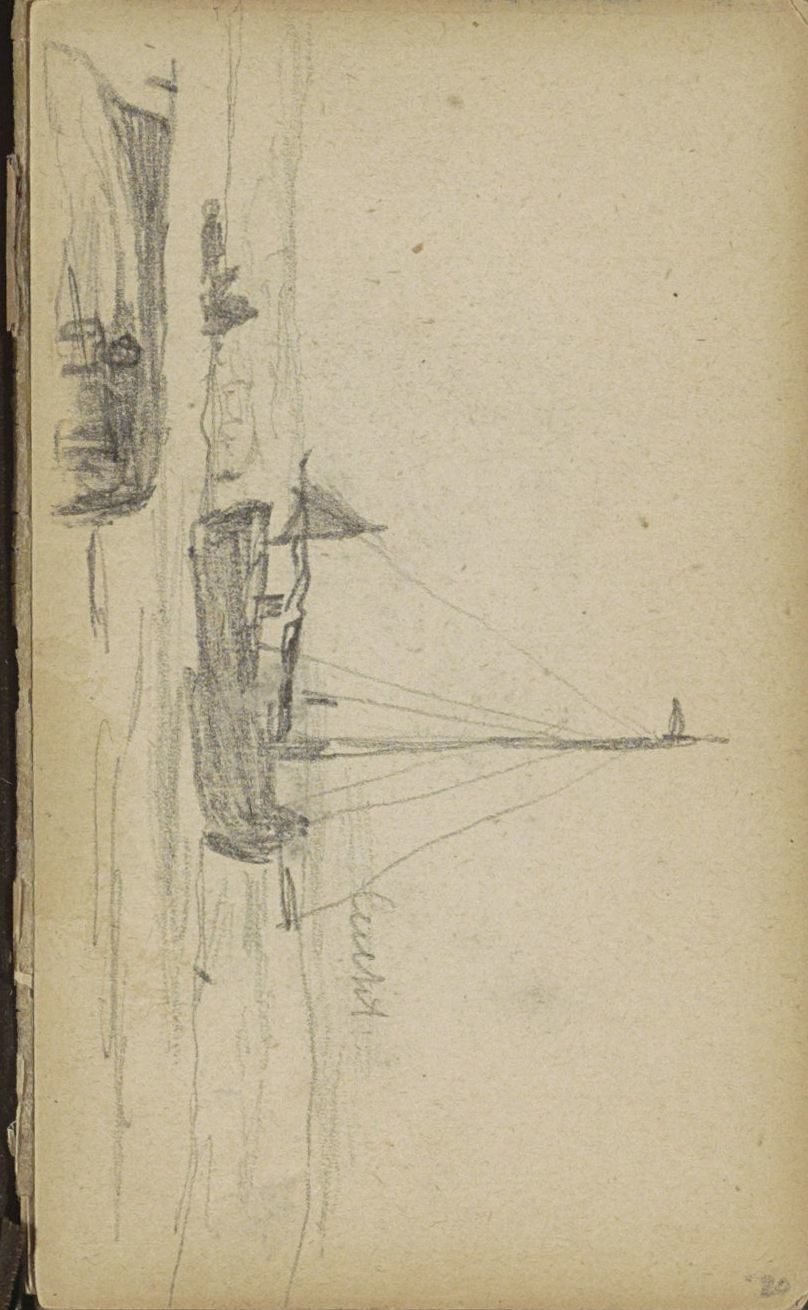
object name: sketchbook leaf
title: Zeilboot aan de vloedlijn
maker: johan hendrik weissenbruch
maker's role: draughtsman, painter, print maker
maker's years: 1824-1903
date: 1834-1903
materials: paper, pencil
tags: sailing-ship, sailing-boat, sea (seascape)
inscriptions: annotation: ‘lucht’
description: Blad 20 recto uit een schetsboek met 32 bladen.